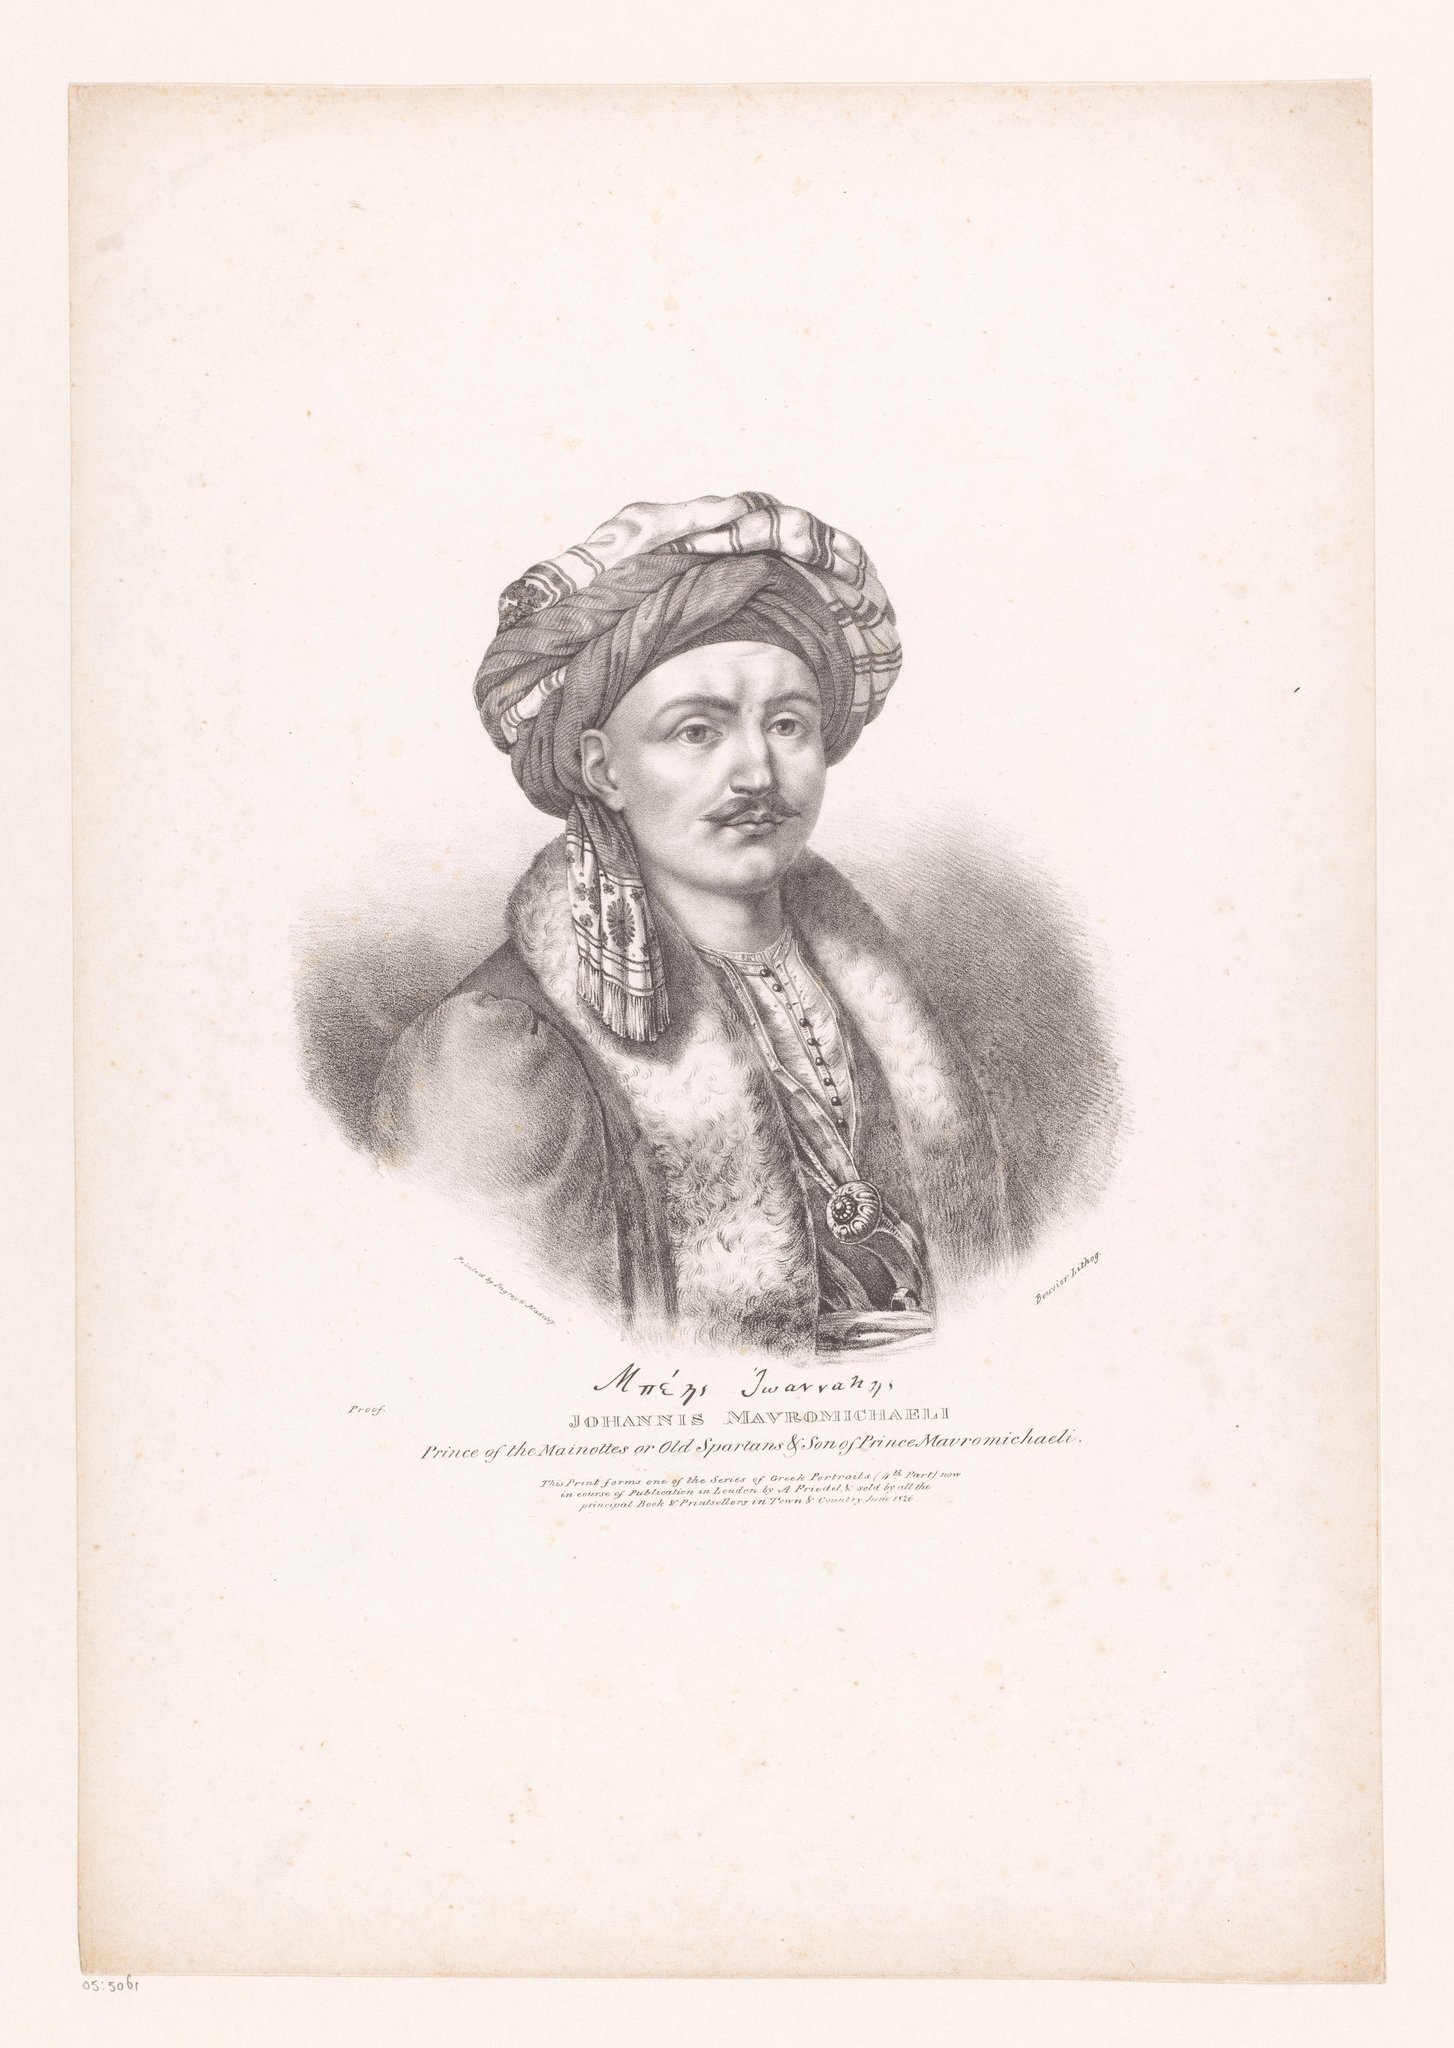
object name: print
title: Portret van Iohannis Mavromichalis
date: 1826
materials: paper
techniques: lithograph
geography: london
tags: moustache, adult man, historical persons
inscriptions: collector's mark: Lugt 2228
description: Prent maakt onderdeel uit van een serie portretten van figuren betrokken bij de Griekse onafhankelijkheidsoorlog. Deze serie is uitgegeven door Adam Friedel in verschillende delen en edities.